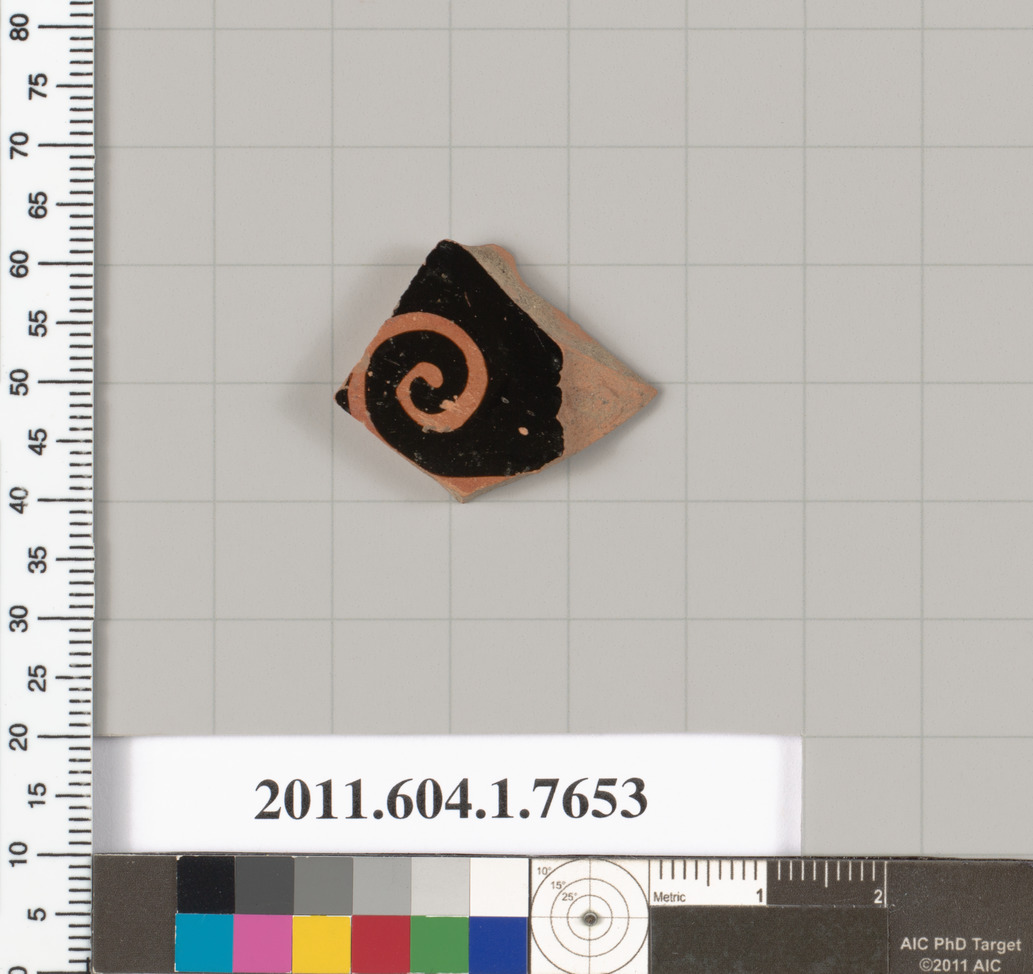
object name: kylix fragment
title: Terracotta fragment of a kylix (drinking cup)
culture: greek, attic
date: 460-450 BCE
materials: terracotta